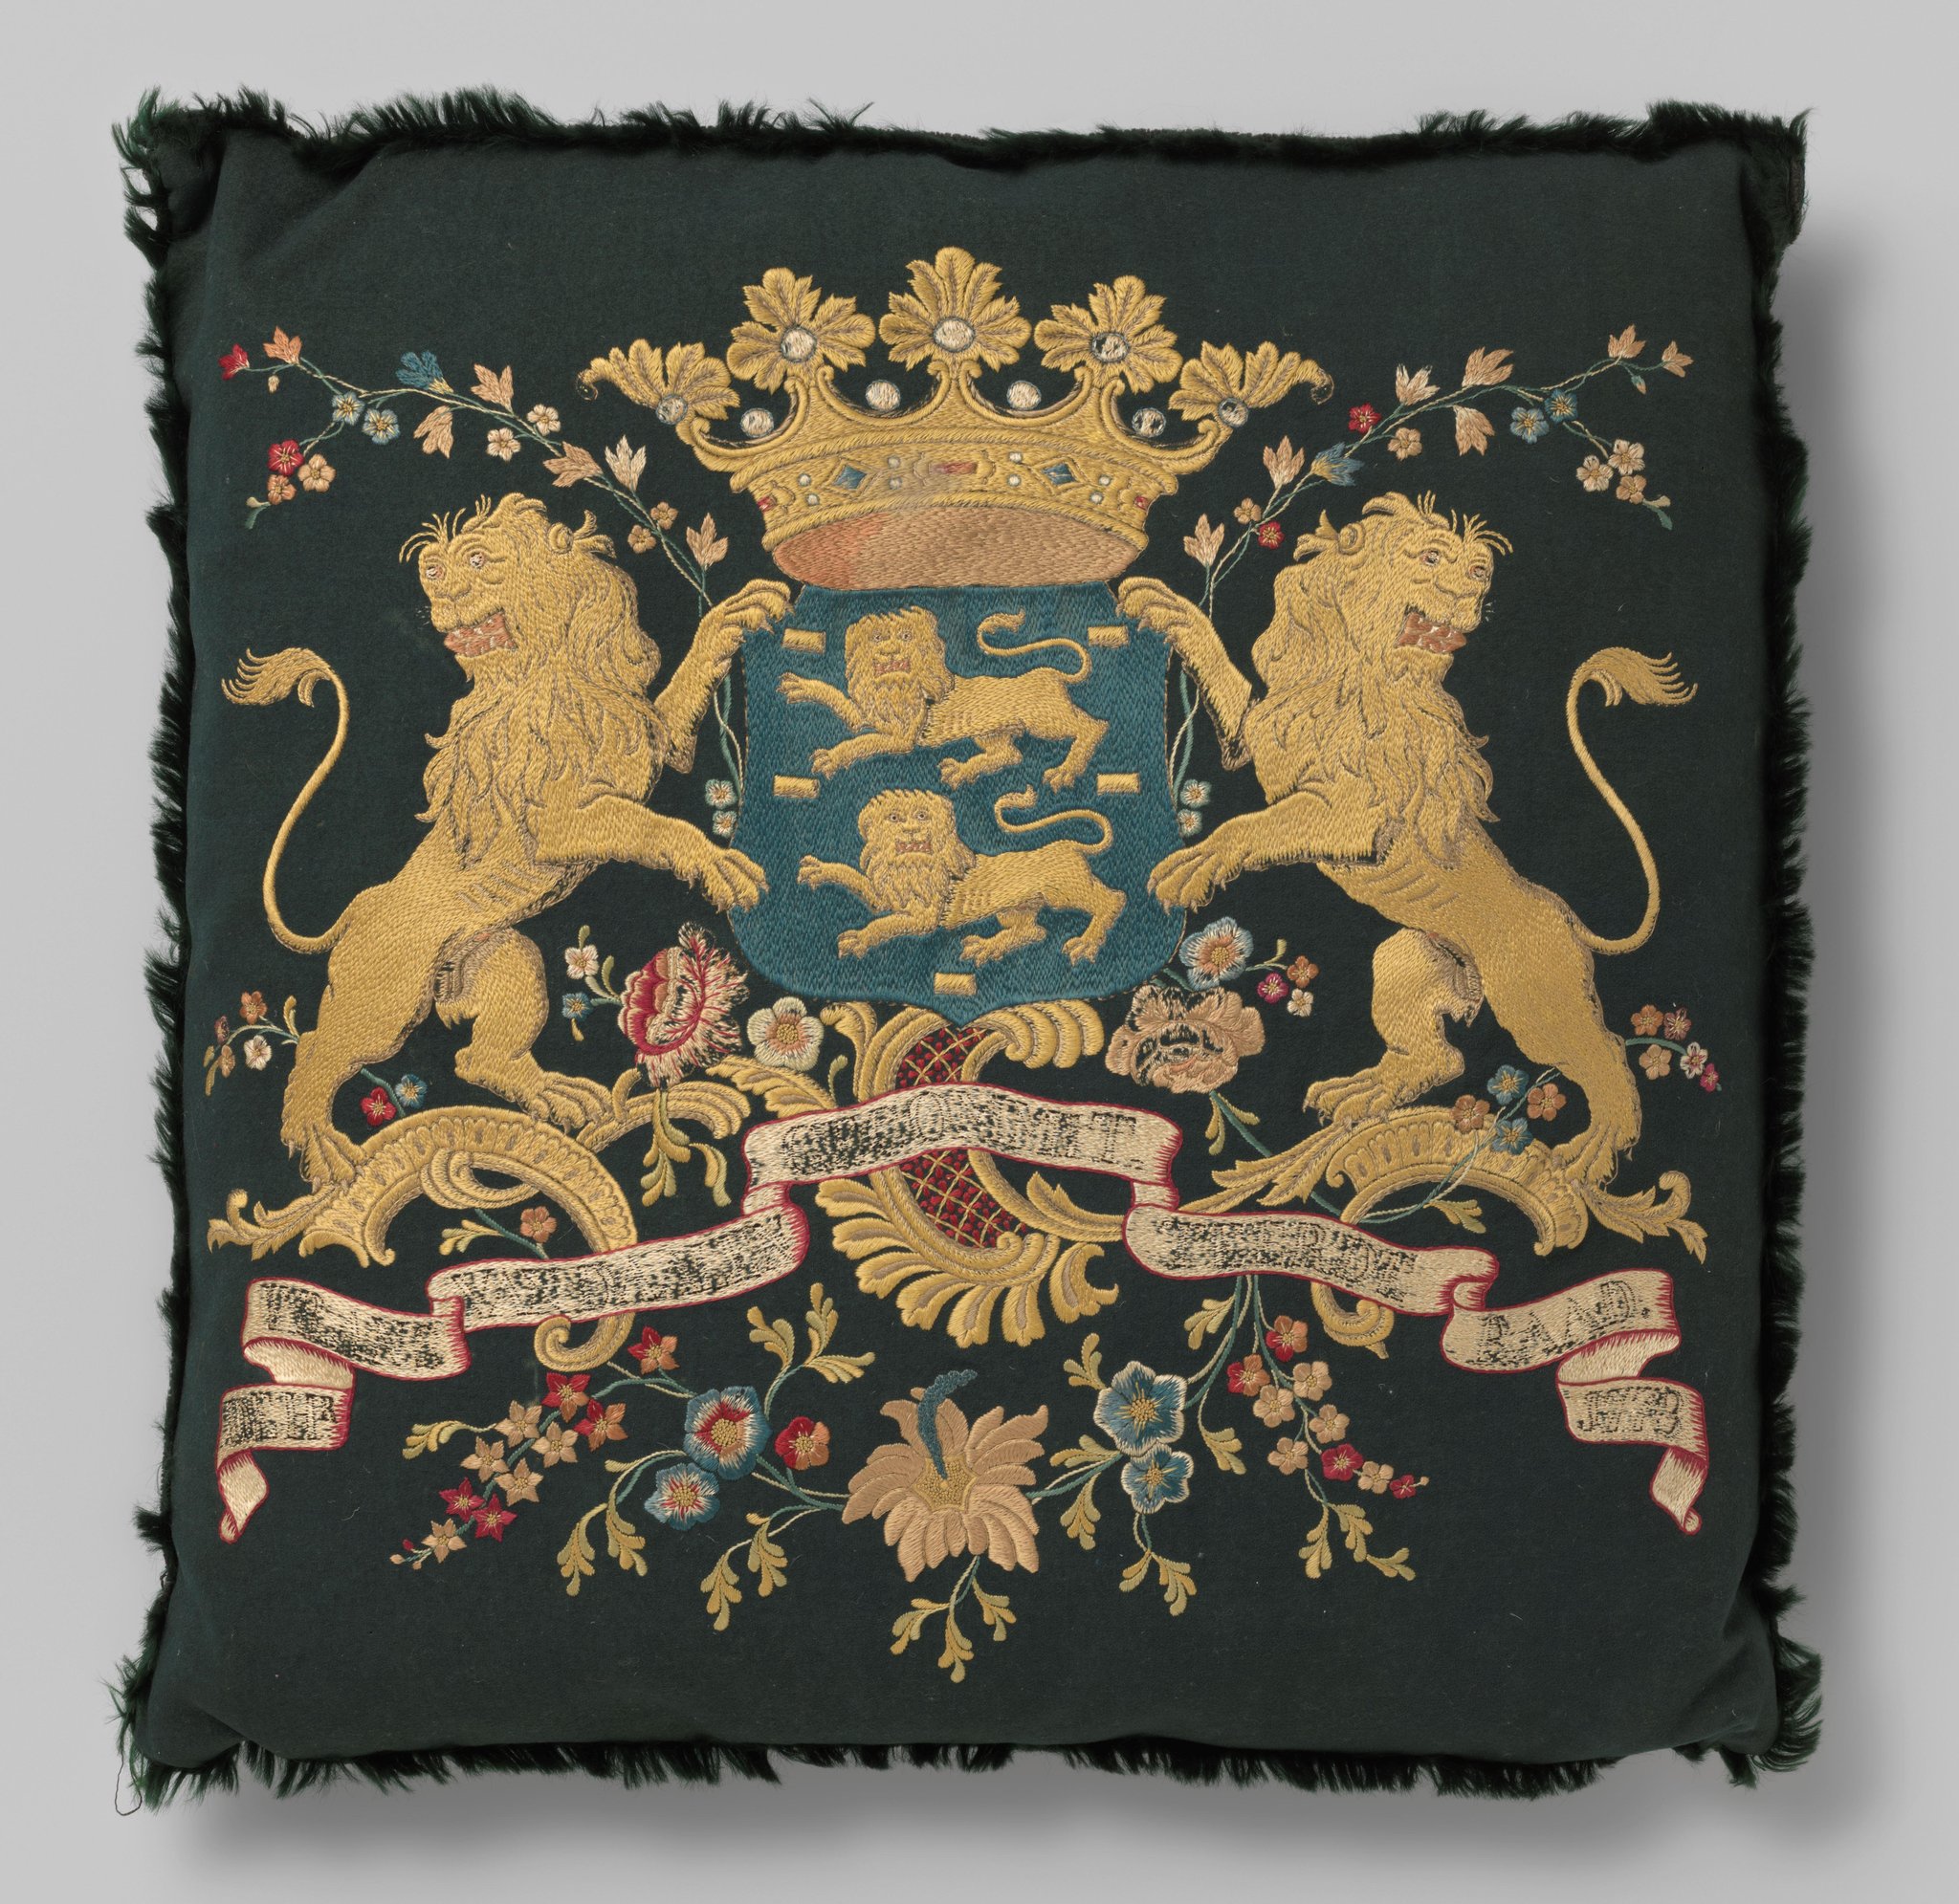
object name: magistratenkussen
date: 1773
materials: silk, wool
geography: northern netherlands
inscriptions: date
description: Magistratenkussen van donkergroen laken met het gekroonde wapenschild van West-Friesland en als schildhouders twee leeuwen, het geheel in zijden borduursel. Onder het wapenschild is een banderol aangebracht met de inscriptie "DE HR. FRANS.VAN.DAALEN.GECOMMIT.TEERDE.RAAD.1773". Het kussen is afgewerkt met een korte donkergroenzijden franje en gevoerd met donkergroen halfwollen damast.